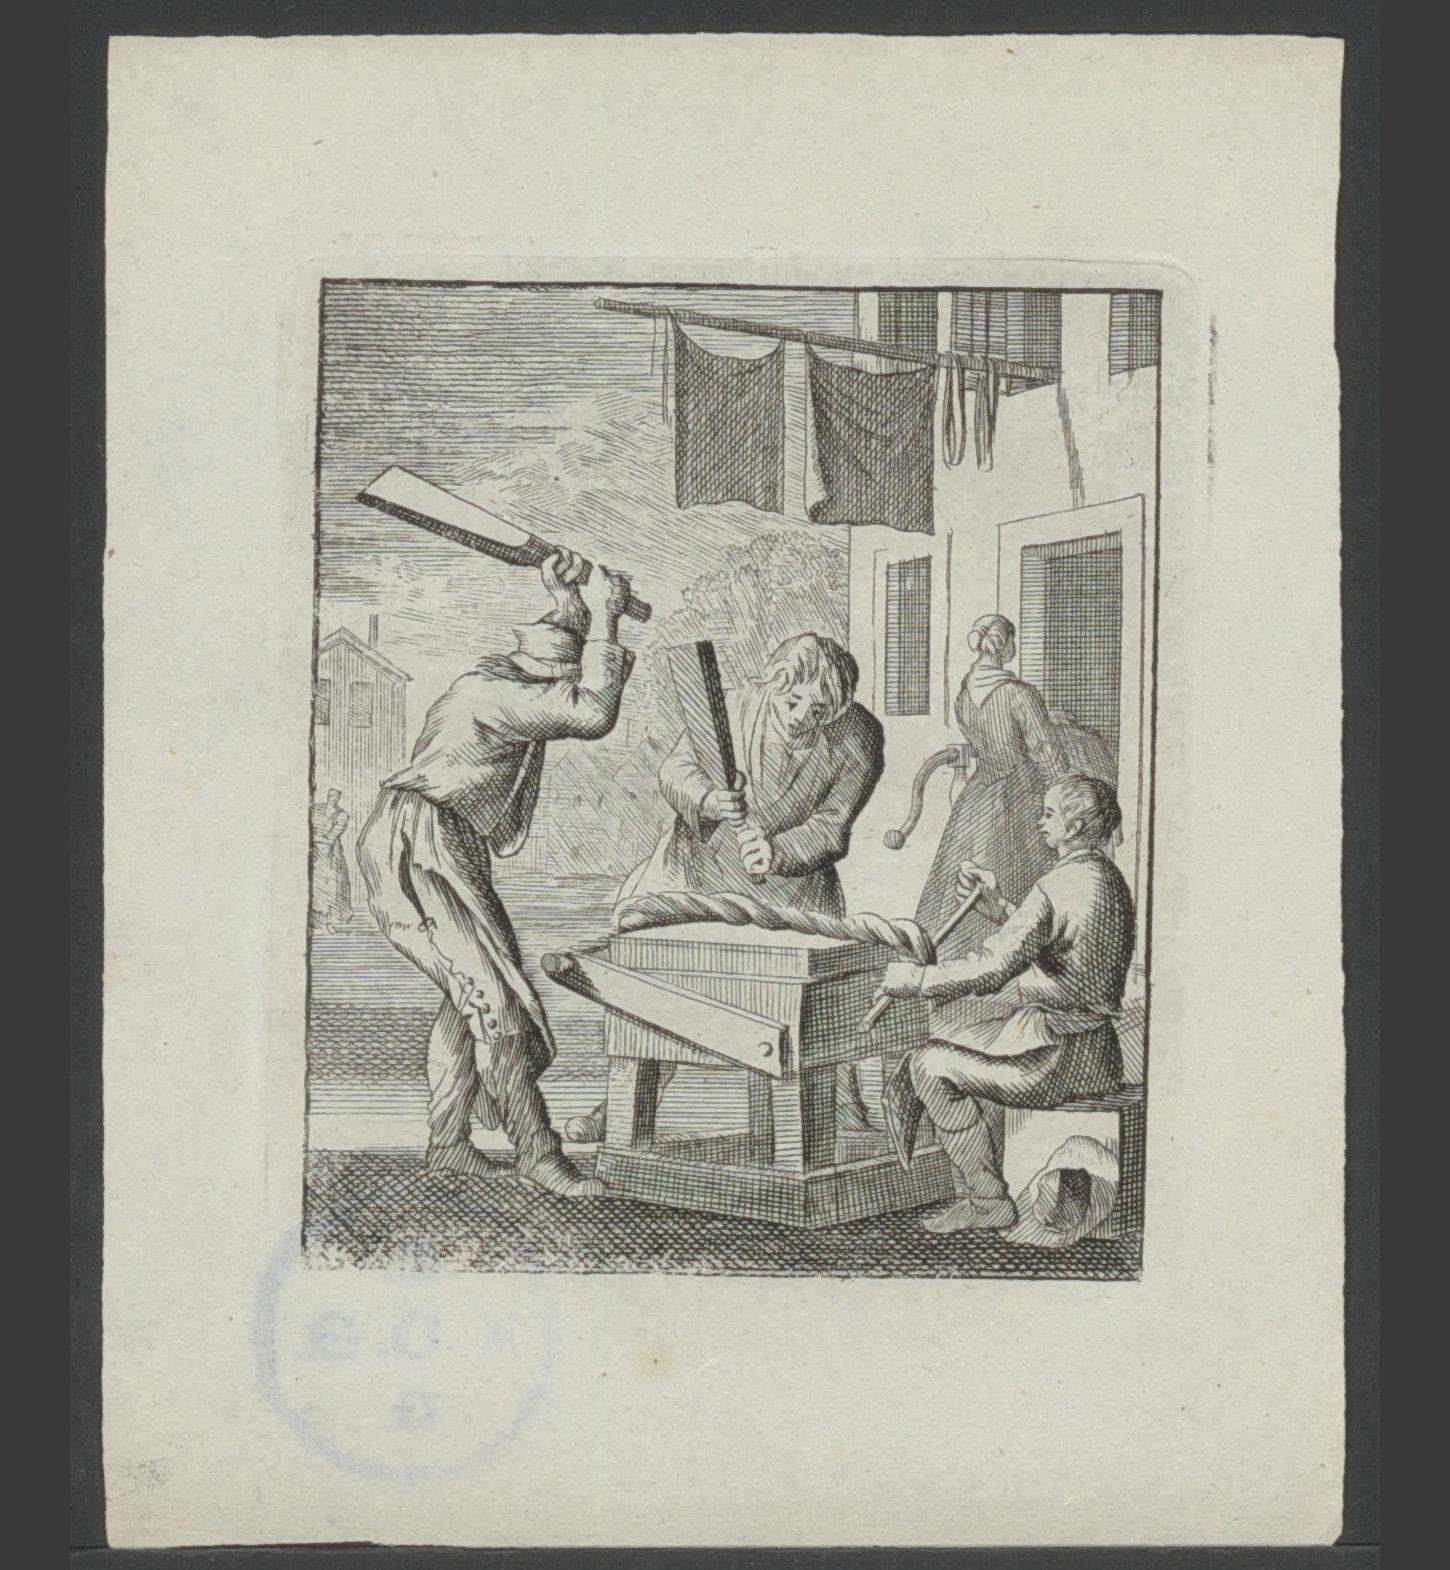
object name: print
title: Garentwijnder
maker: Anonymous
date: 1694-1799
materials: paper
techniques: engraving, etching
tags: handicrafts, craftsman at work, materials ~ textile industry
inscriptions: collector's mark: Lugt 1641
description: Onderwerpsrubrieken binnen de Atlas Zeden en Gewoonten: Handel, Nijverheid en Verkeer, Beroep en bedrijf, Complete suites.